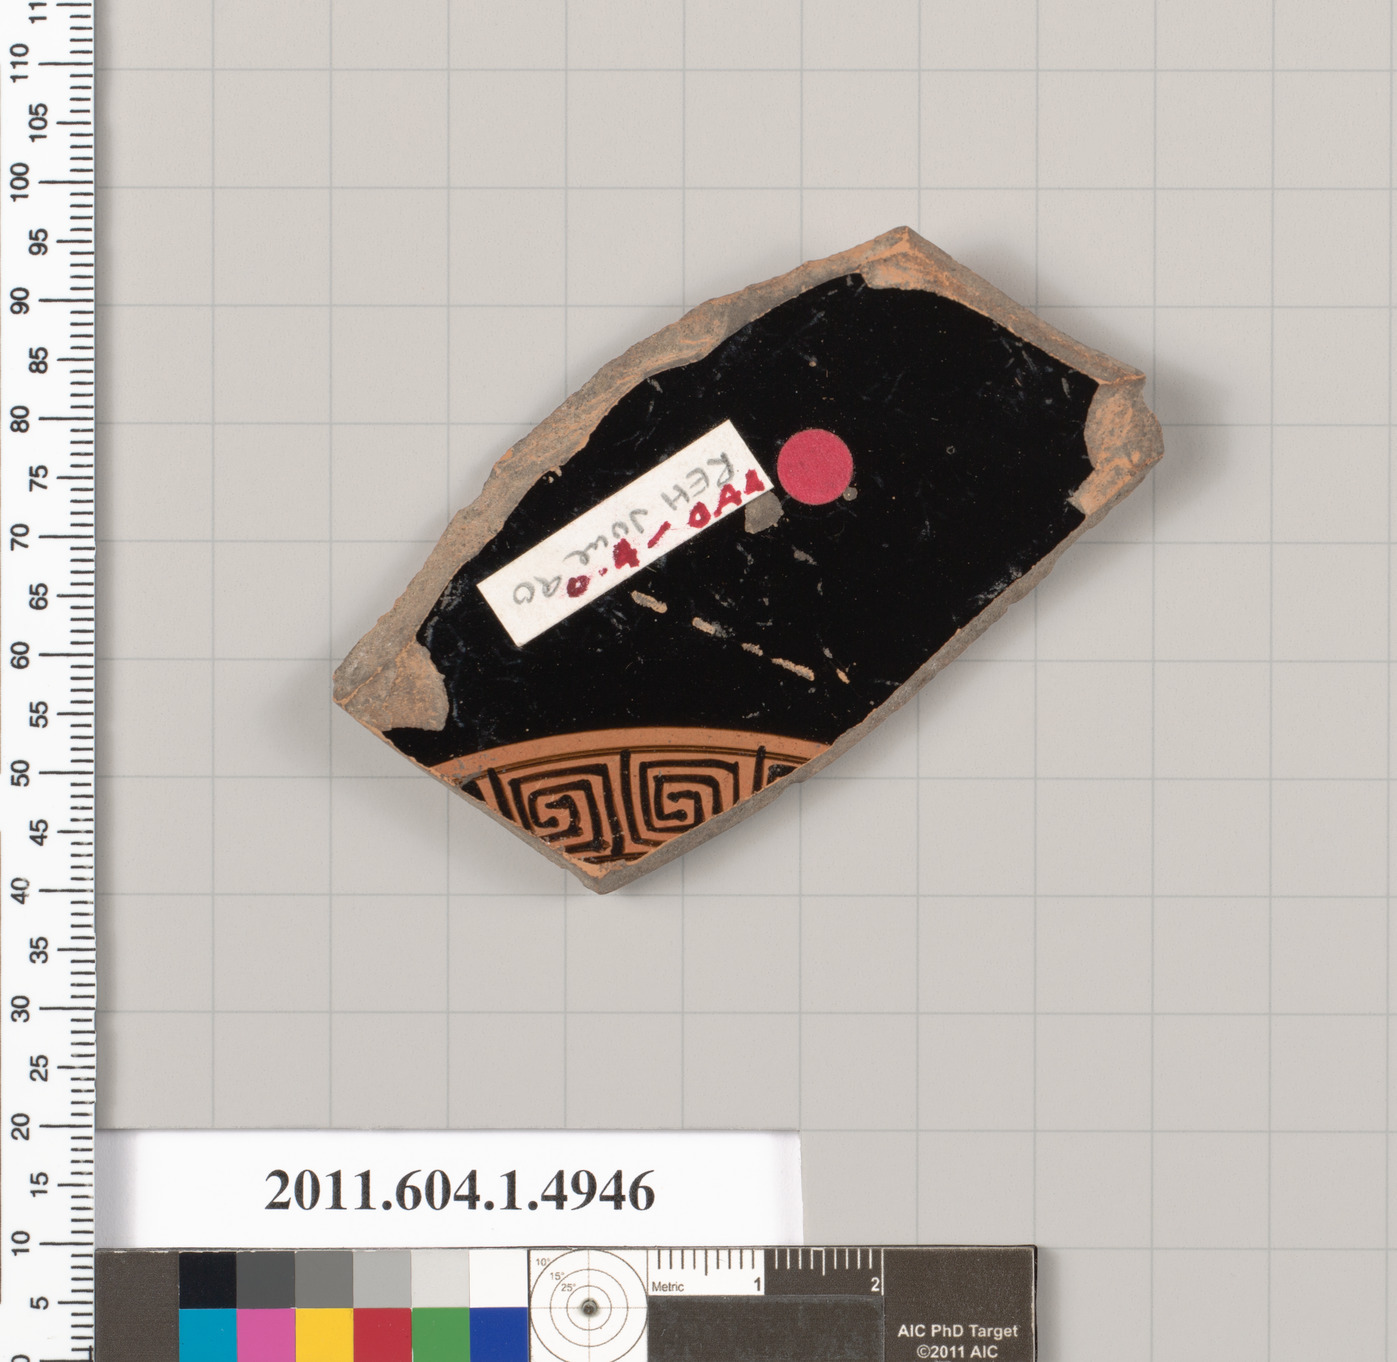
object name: kylix fragment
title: Terracotta fragment of a kylix (drinking cup)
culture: greek, attic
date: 475-451 BCE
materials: terracotta